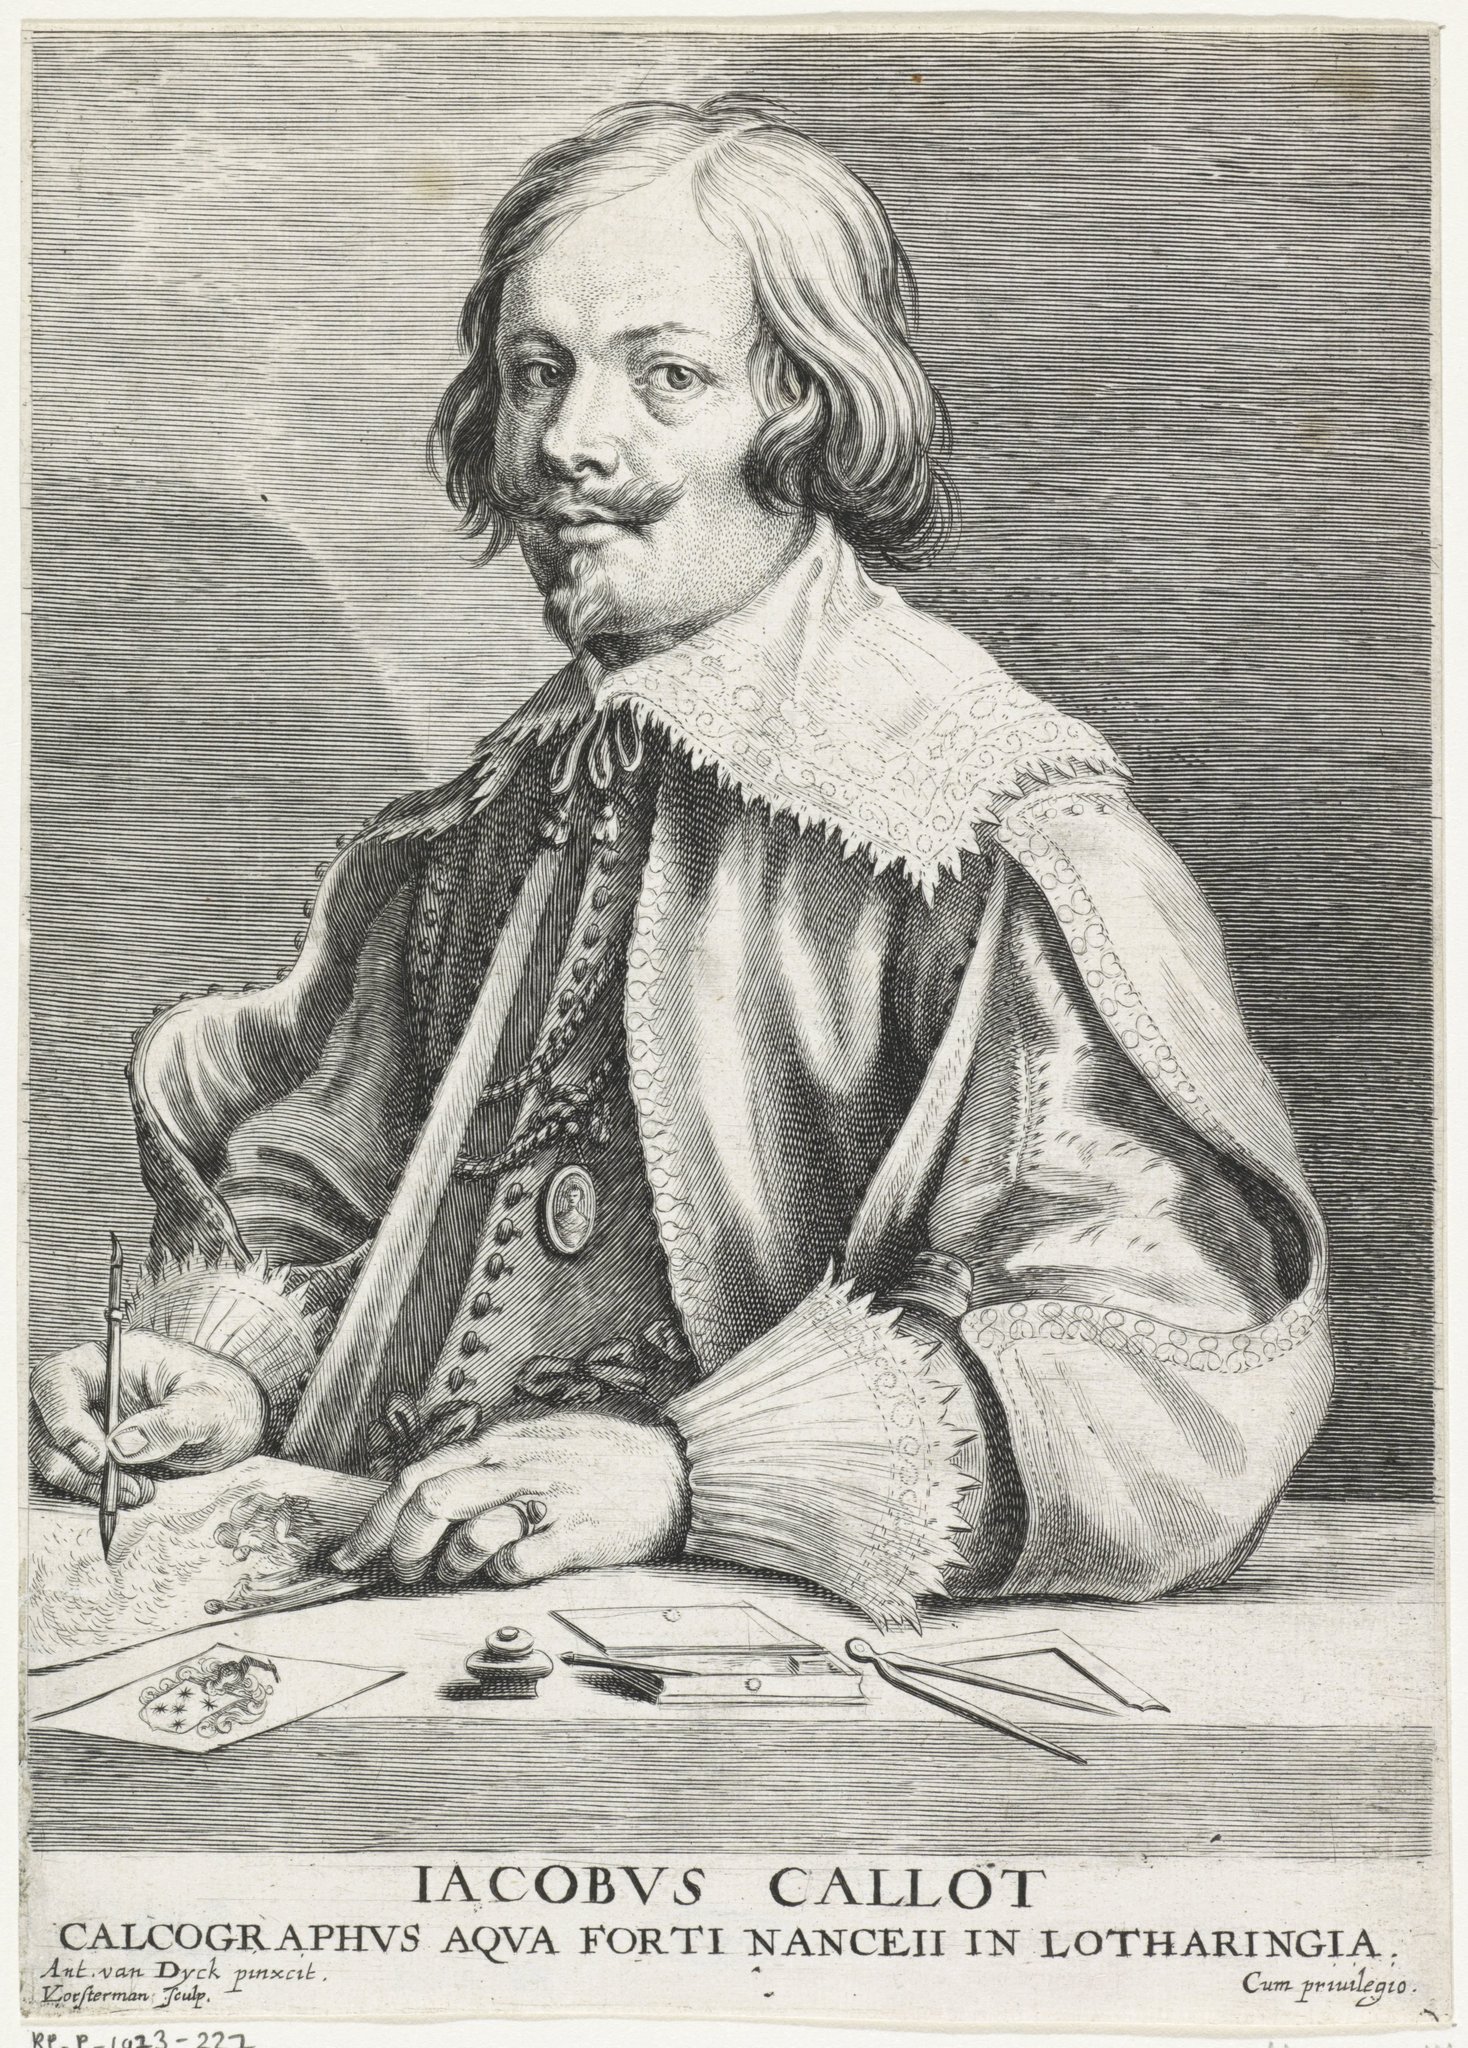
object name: print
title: Iconographie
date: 1646-1675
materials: paper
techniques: engraving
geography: antwerp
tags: print maker, draughtsman, jacques callot, print, e.g.: engraving, etching, lithograph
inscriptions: collector's mark: Lugt 2228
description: Prent gebruikt voor: Icones principum, virorum doctorum, pictorum, chalcographorum, statuariorum nec non amatorum pictoriae artis numero centum ab Ant. van Dyck ad vivum expressae ejusque sumptibus aeri incisae. Antwerpen: Gillis Hendricx, [1645-1646].